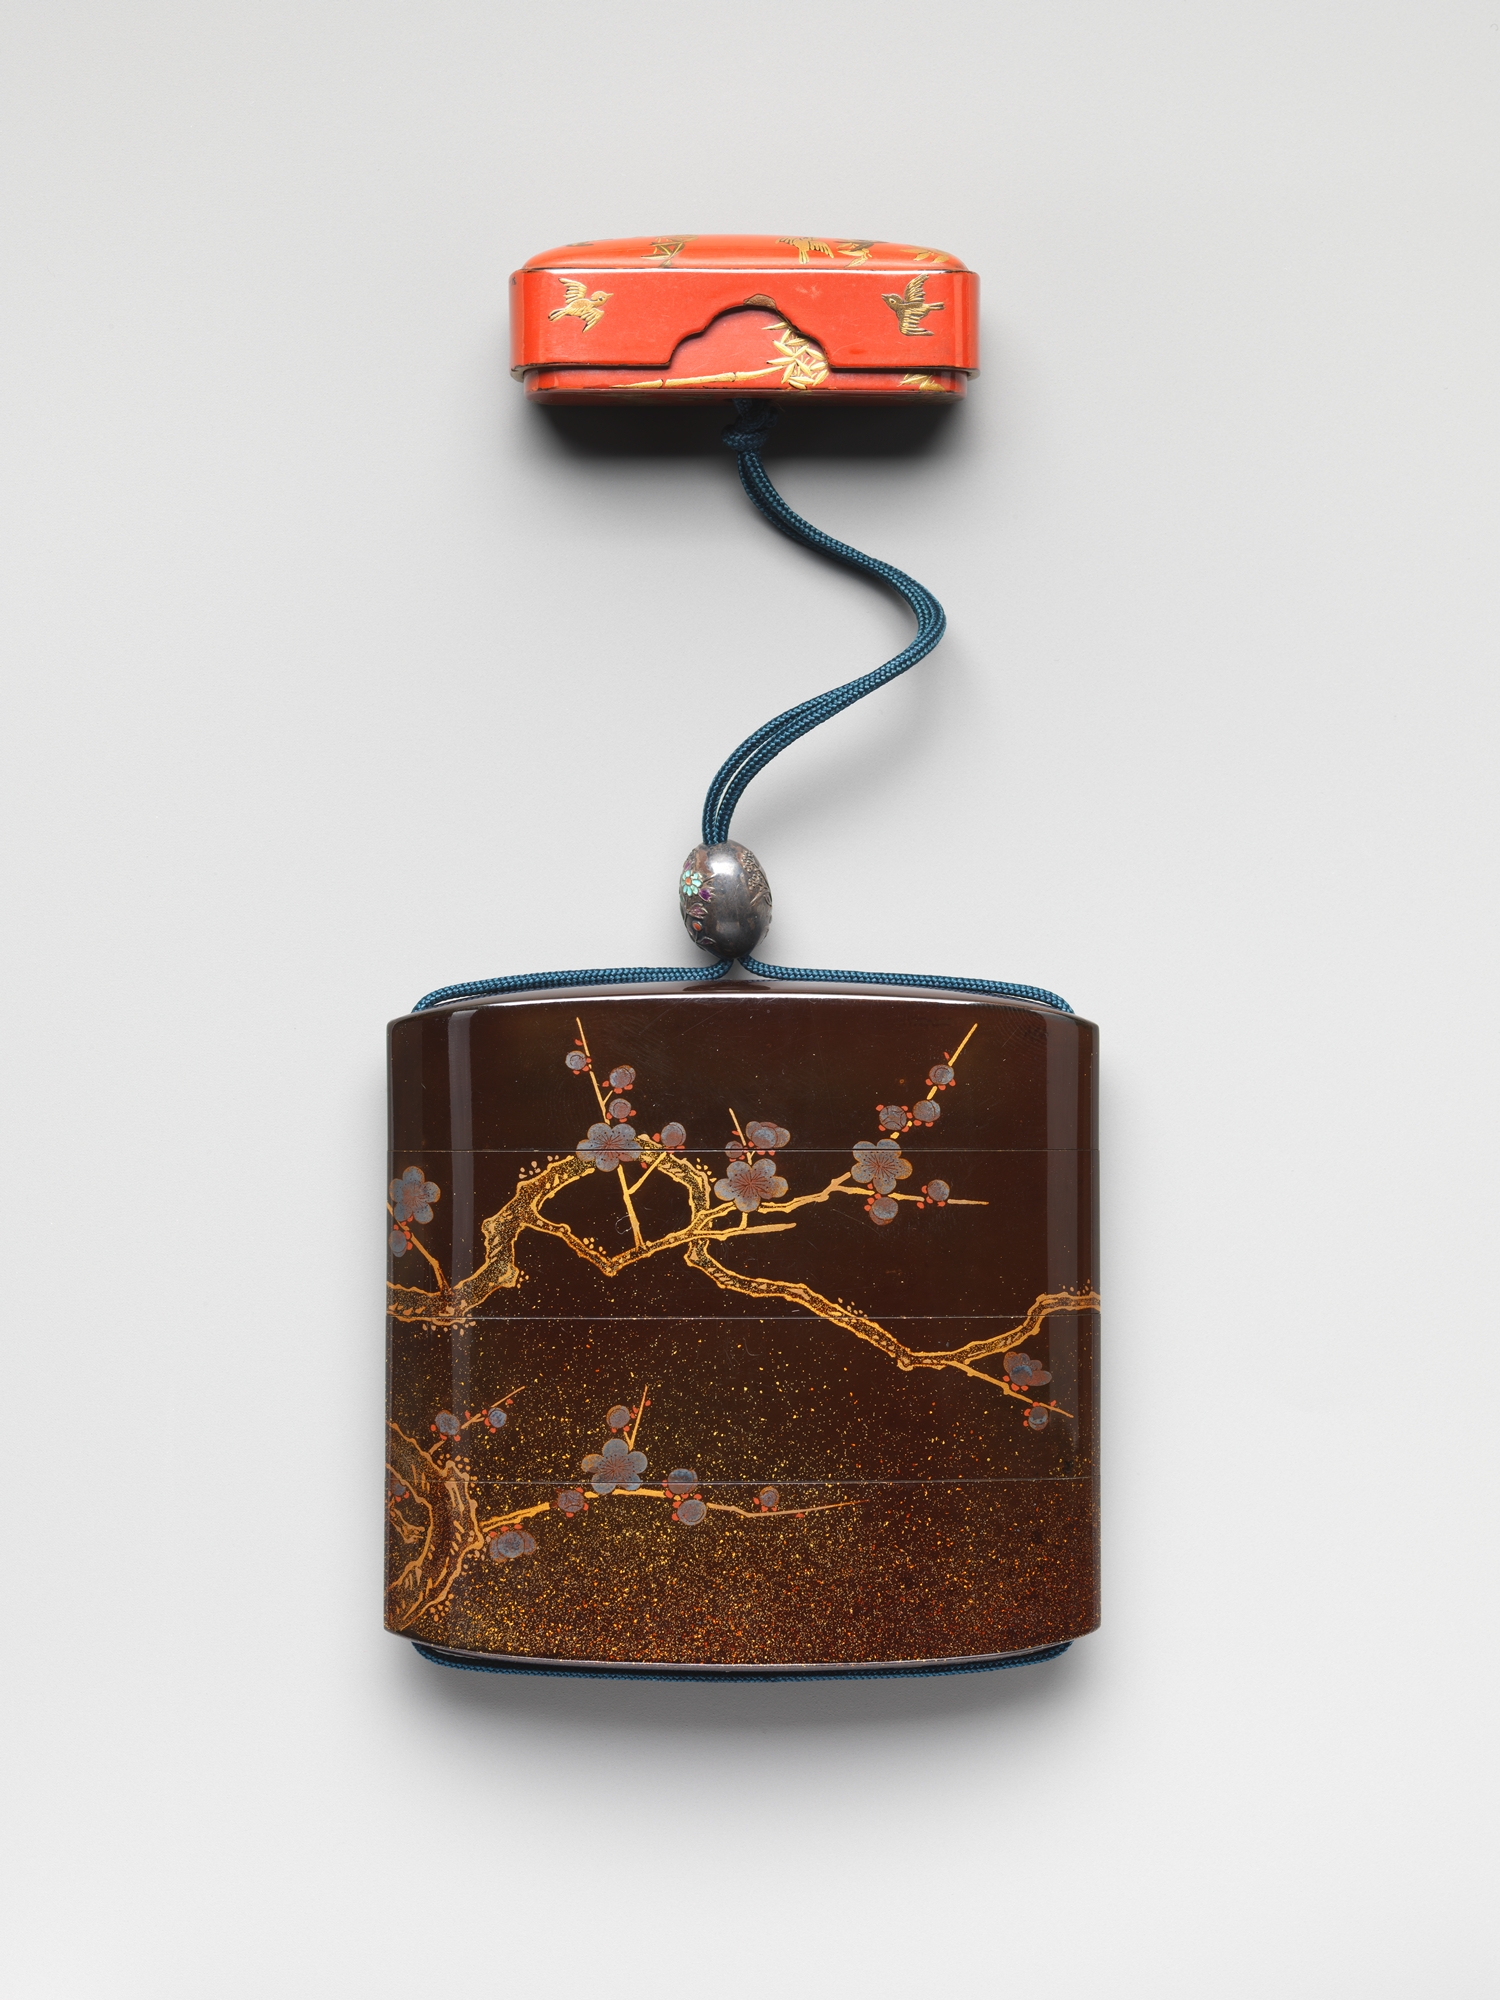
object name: inrō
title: Inrō with Bird on a Blossoming Plum Tree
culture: japanese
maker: koma yasutada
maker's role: artist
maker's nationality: japanese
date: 1801-1900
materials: enamel, gold, lacquer, metal alloy, silver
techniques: hiramakie, maki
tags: birds,flowers,trees